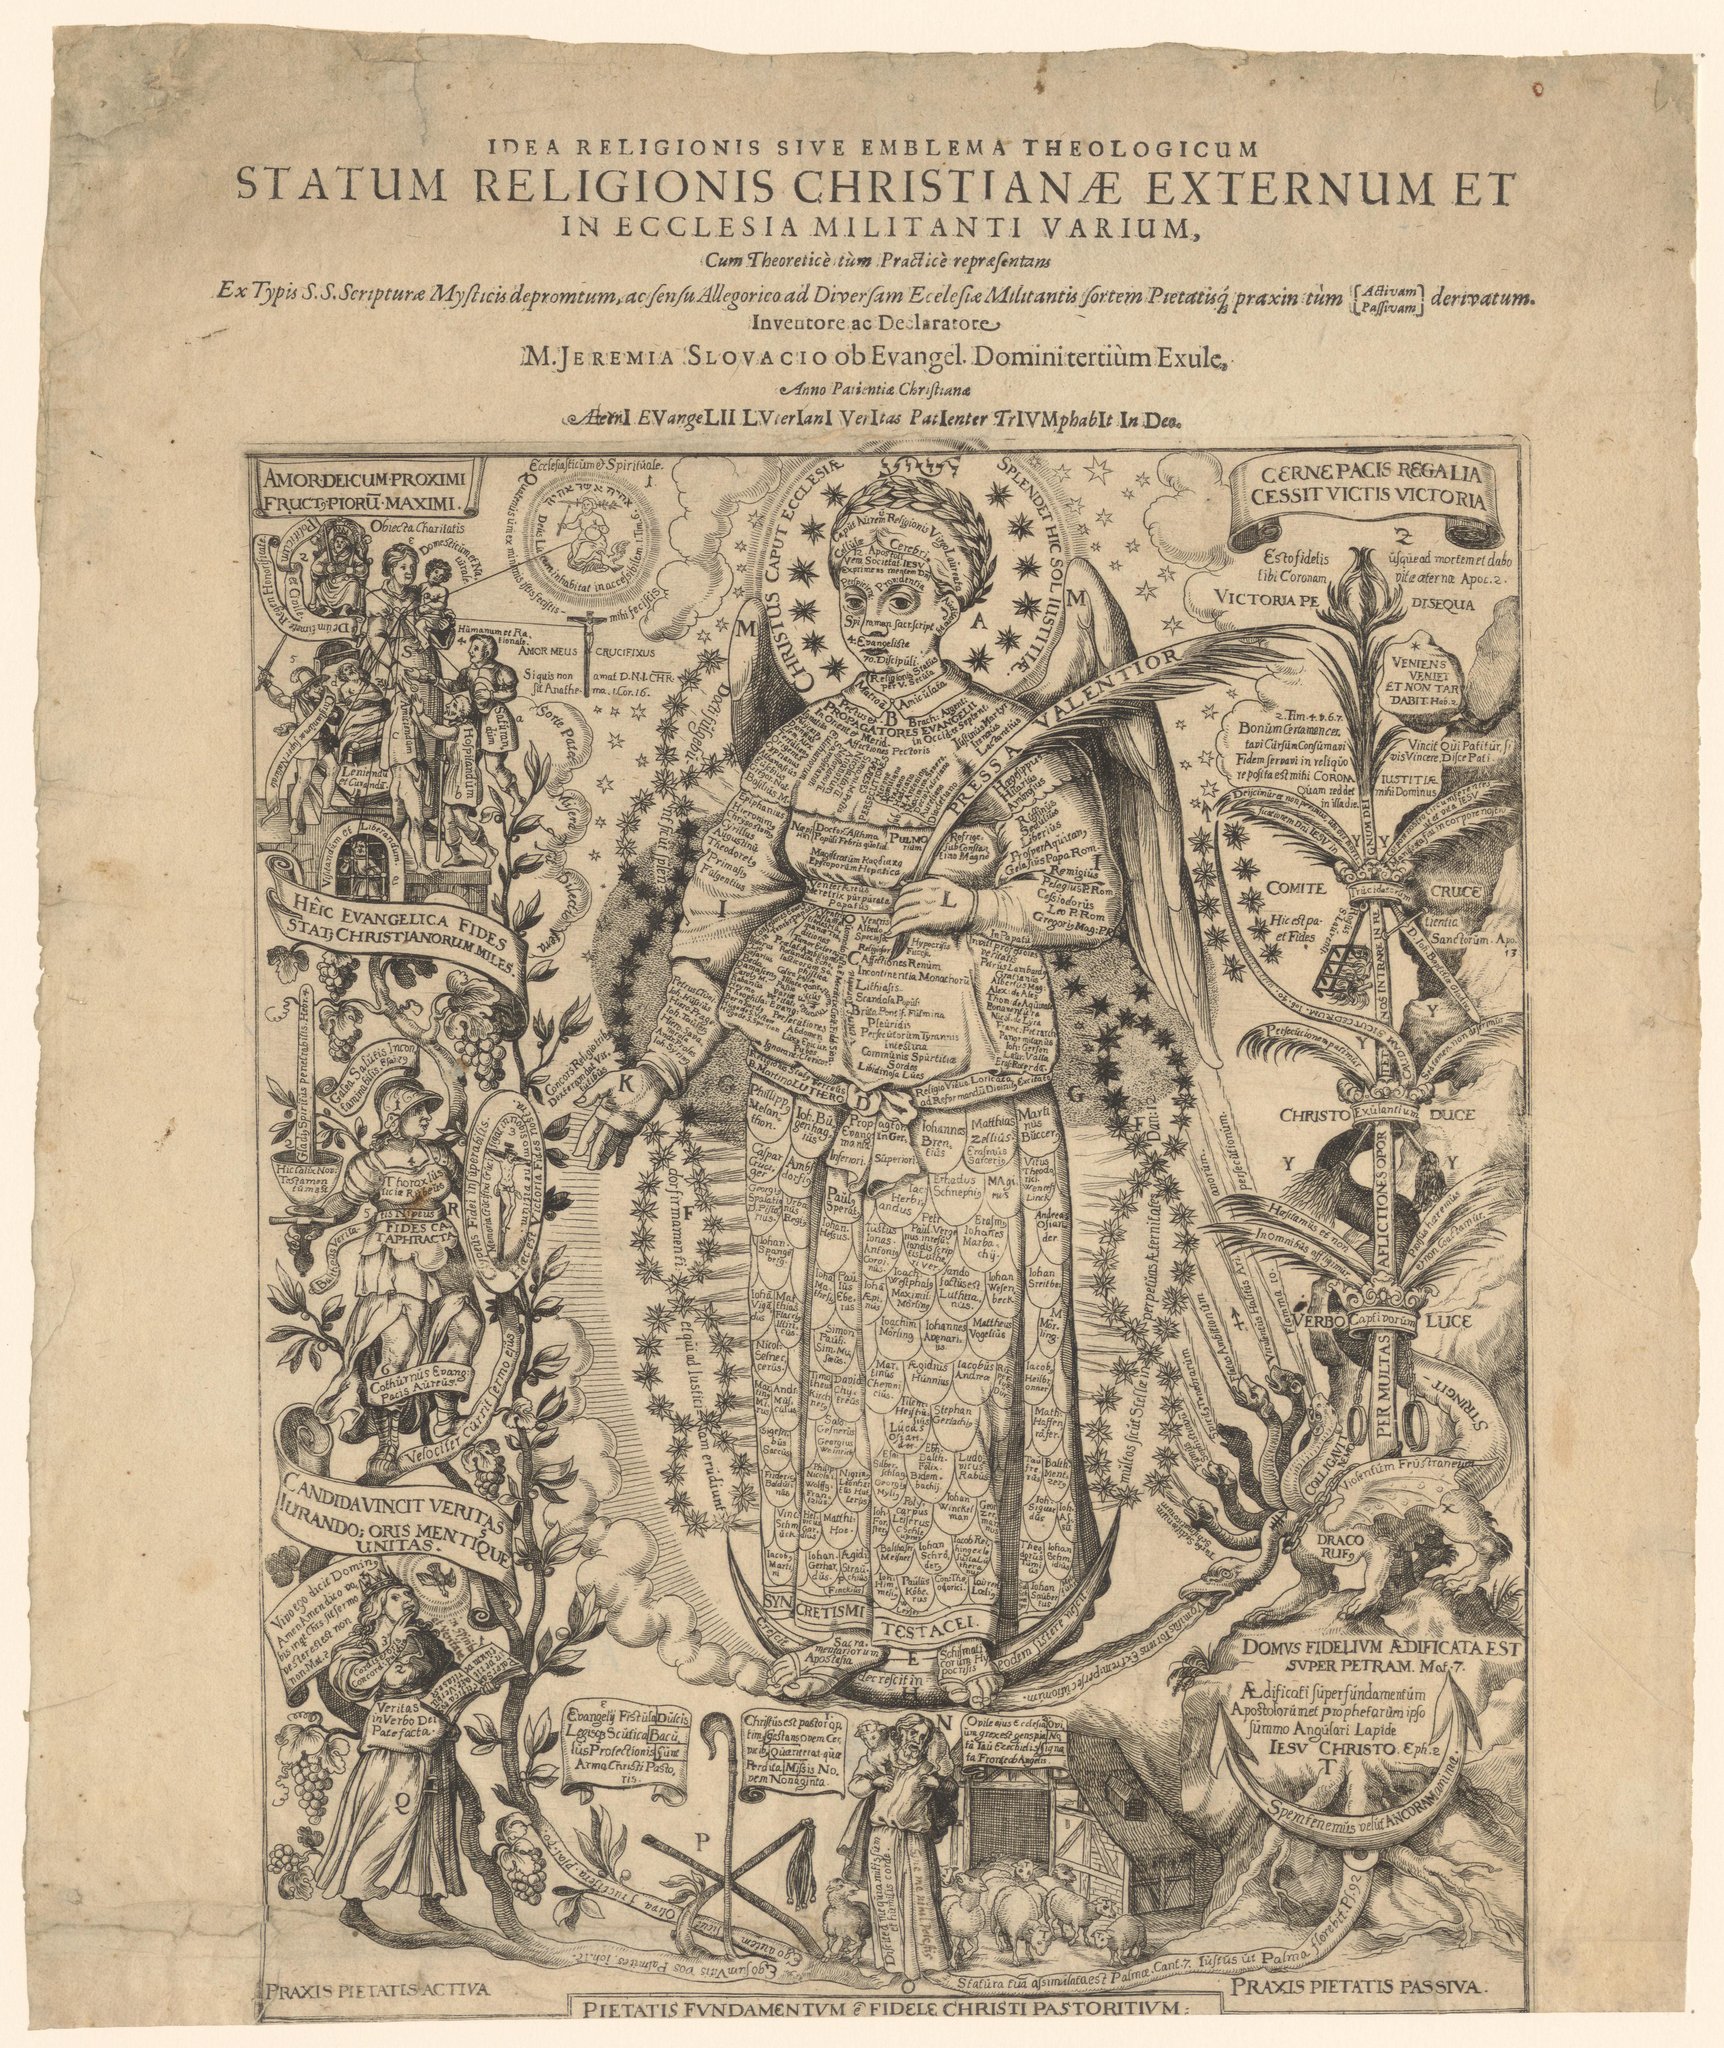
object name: text sheet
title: Allegorie op het Christendom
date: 1630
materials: paper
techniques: etching, letterpress printing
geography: rothenburg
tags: a pregnant woman, clothed with the sun and standing on the moon, appears; she is threatened by a red dragon with a long tail and seven heads - gg - mary as the apocalyptic woman, christian doctrine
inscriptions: collector's mark: Lugt 2228, collector's mark: Lugt 2760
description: Tekst in het Latijn in de voorstelling, rondom de wijntakken en het anker, en in boekdruk boven de plaatrand.